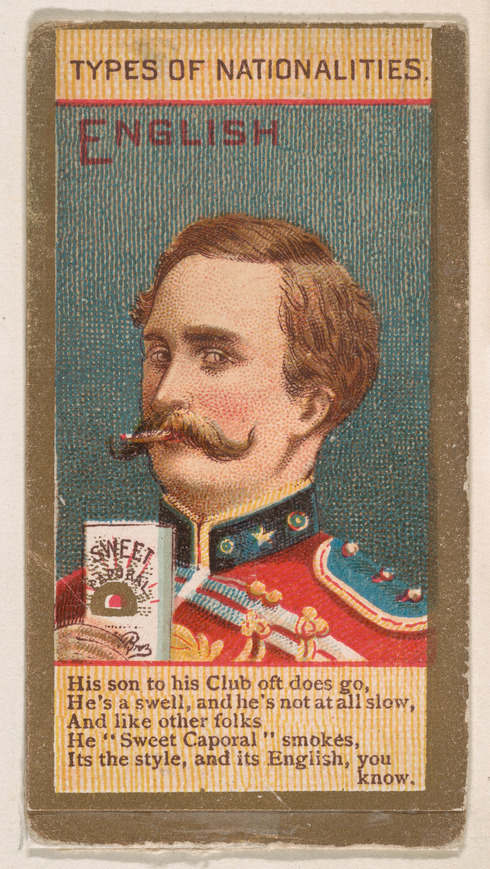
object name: print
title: English, from Types of Nationalities (N240) issued by Kinney Bros.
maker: kinney brothers tobacco company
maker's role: publisher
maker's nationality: american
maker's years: 1869-2011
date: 1890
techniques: color lithograph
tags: men,smoking